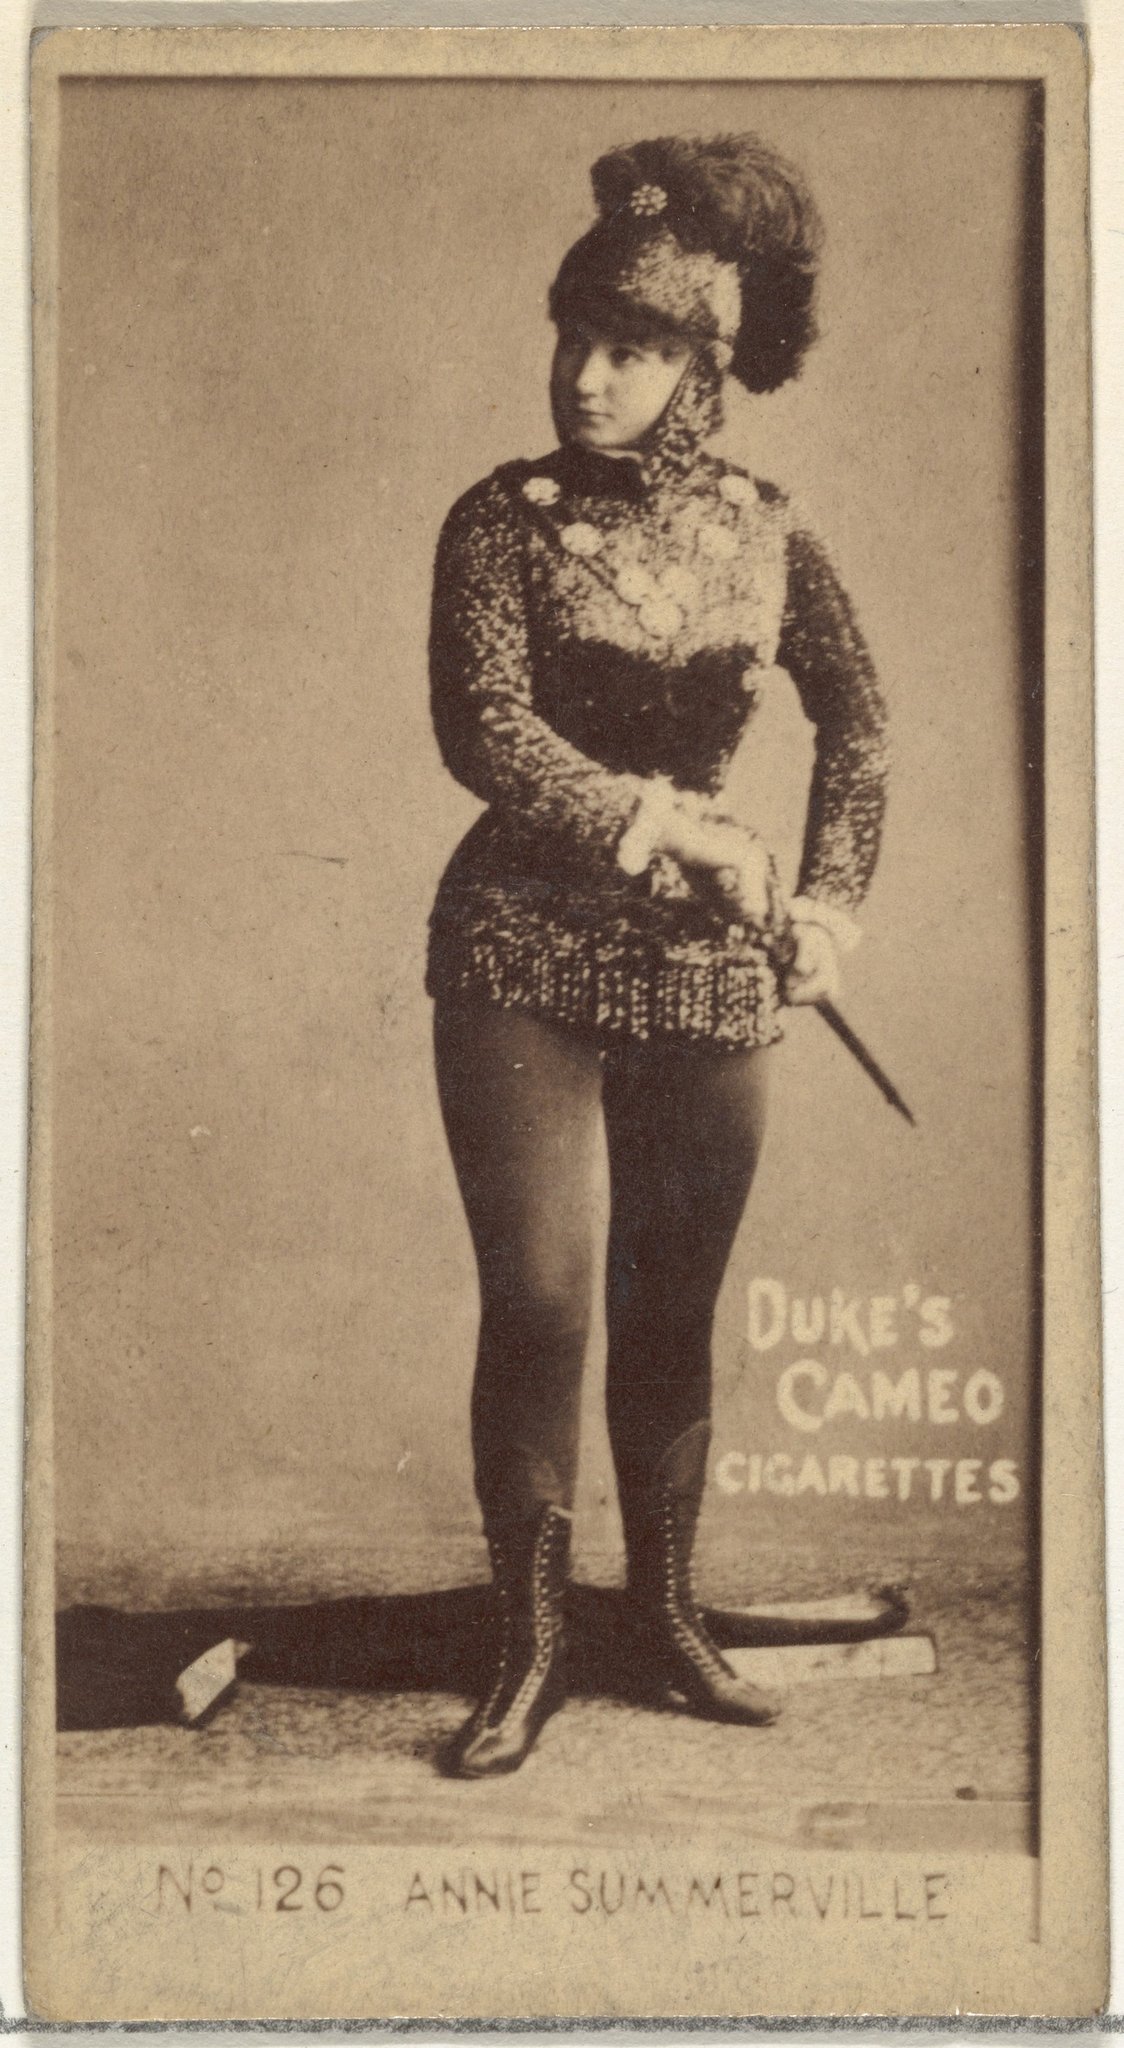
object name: photograph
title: Card Number 126, Annie Summerville, from the Actors and Actresses series (N145-4) issued by Duke Sons & Co. to promote Cameo Cigarettes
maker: w. duke, sons & co.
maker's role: publisher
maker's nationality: american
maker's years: 1870-1920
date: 1880-1889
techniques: albumen silver print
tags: portraits,women,actresses